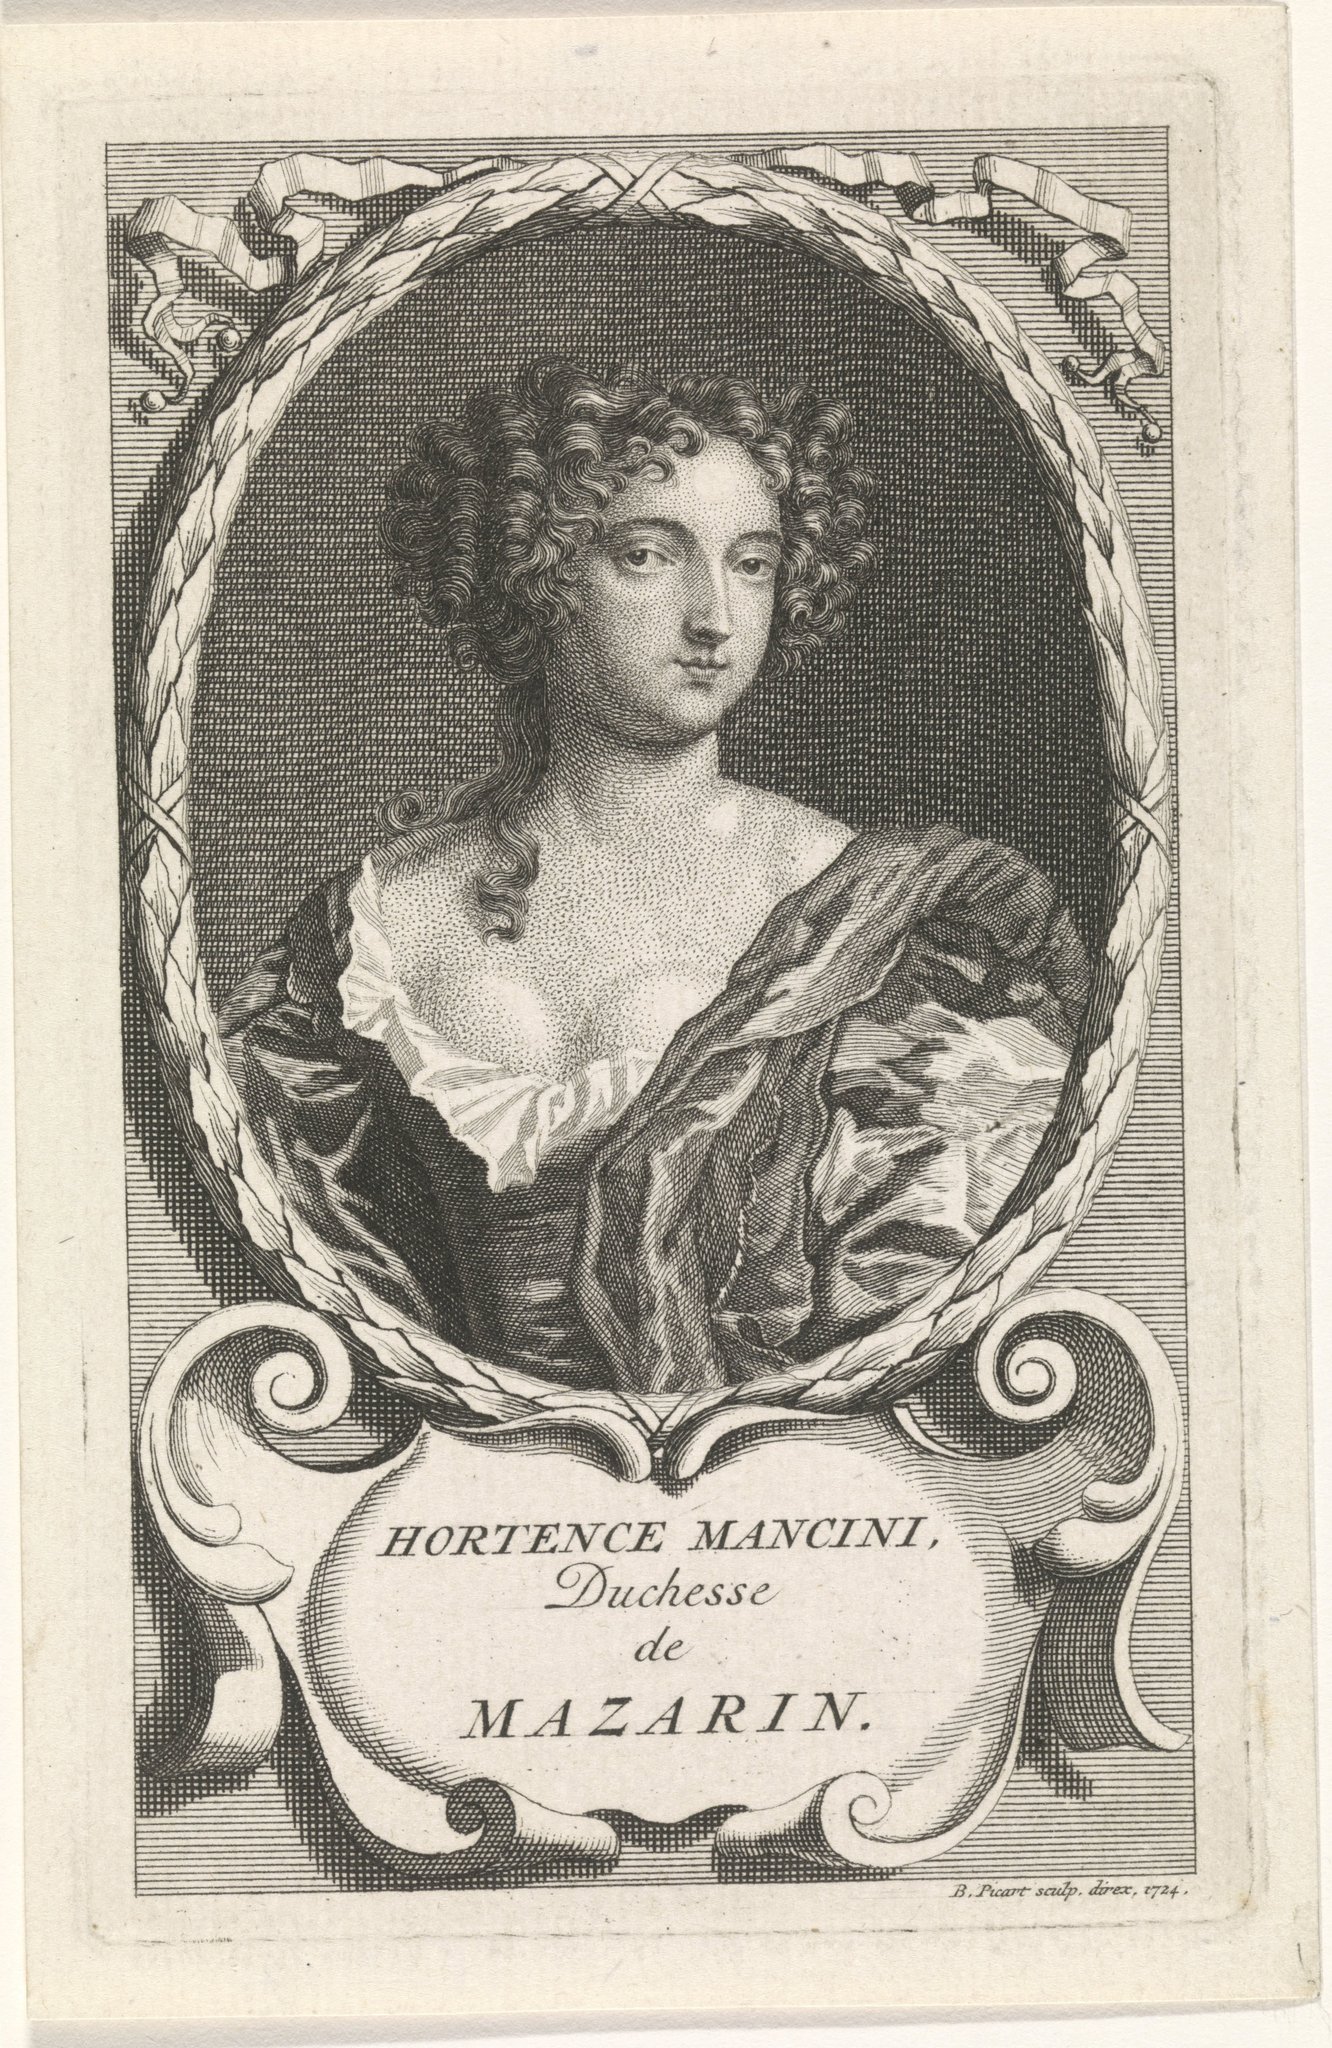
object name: print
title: Portret van Hortense Mancini, hertogin van Mazarin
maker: bernard picart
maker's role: draughtsman, print maker, publisher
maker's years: 1673-1733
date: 1724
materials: paper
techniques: engraving, etching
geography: amsterdam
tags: chelsea, hortense mancini hertogin van mazarin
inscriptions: collector's mark: Lugt 240